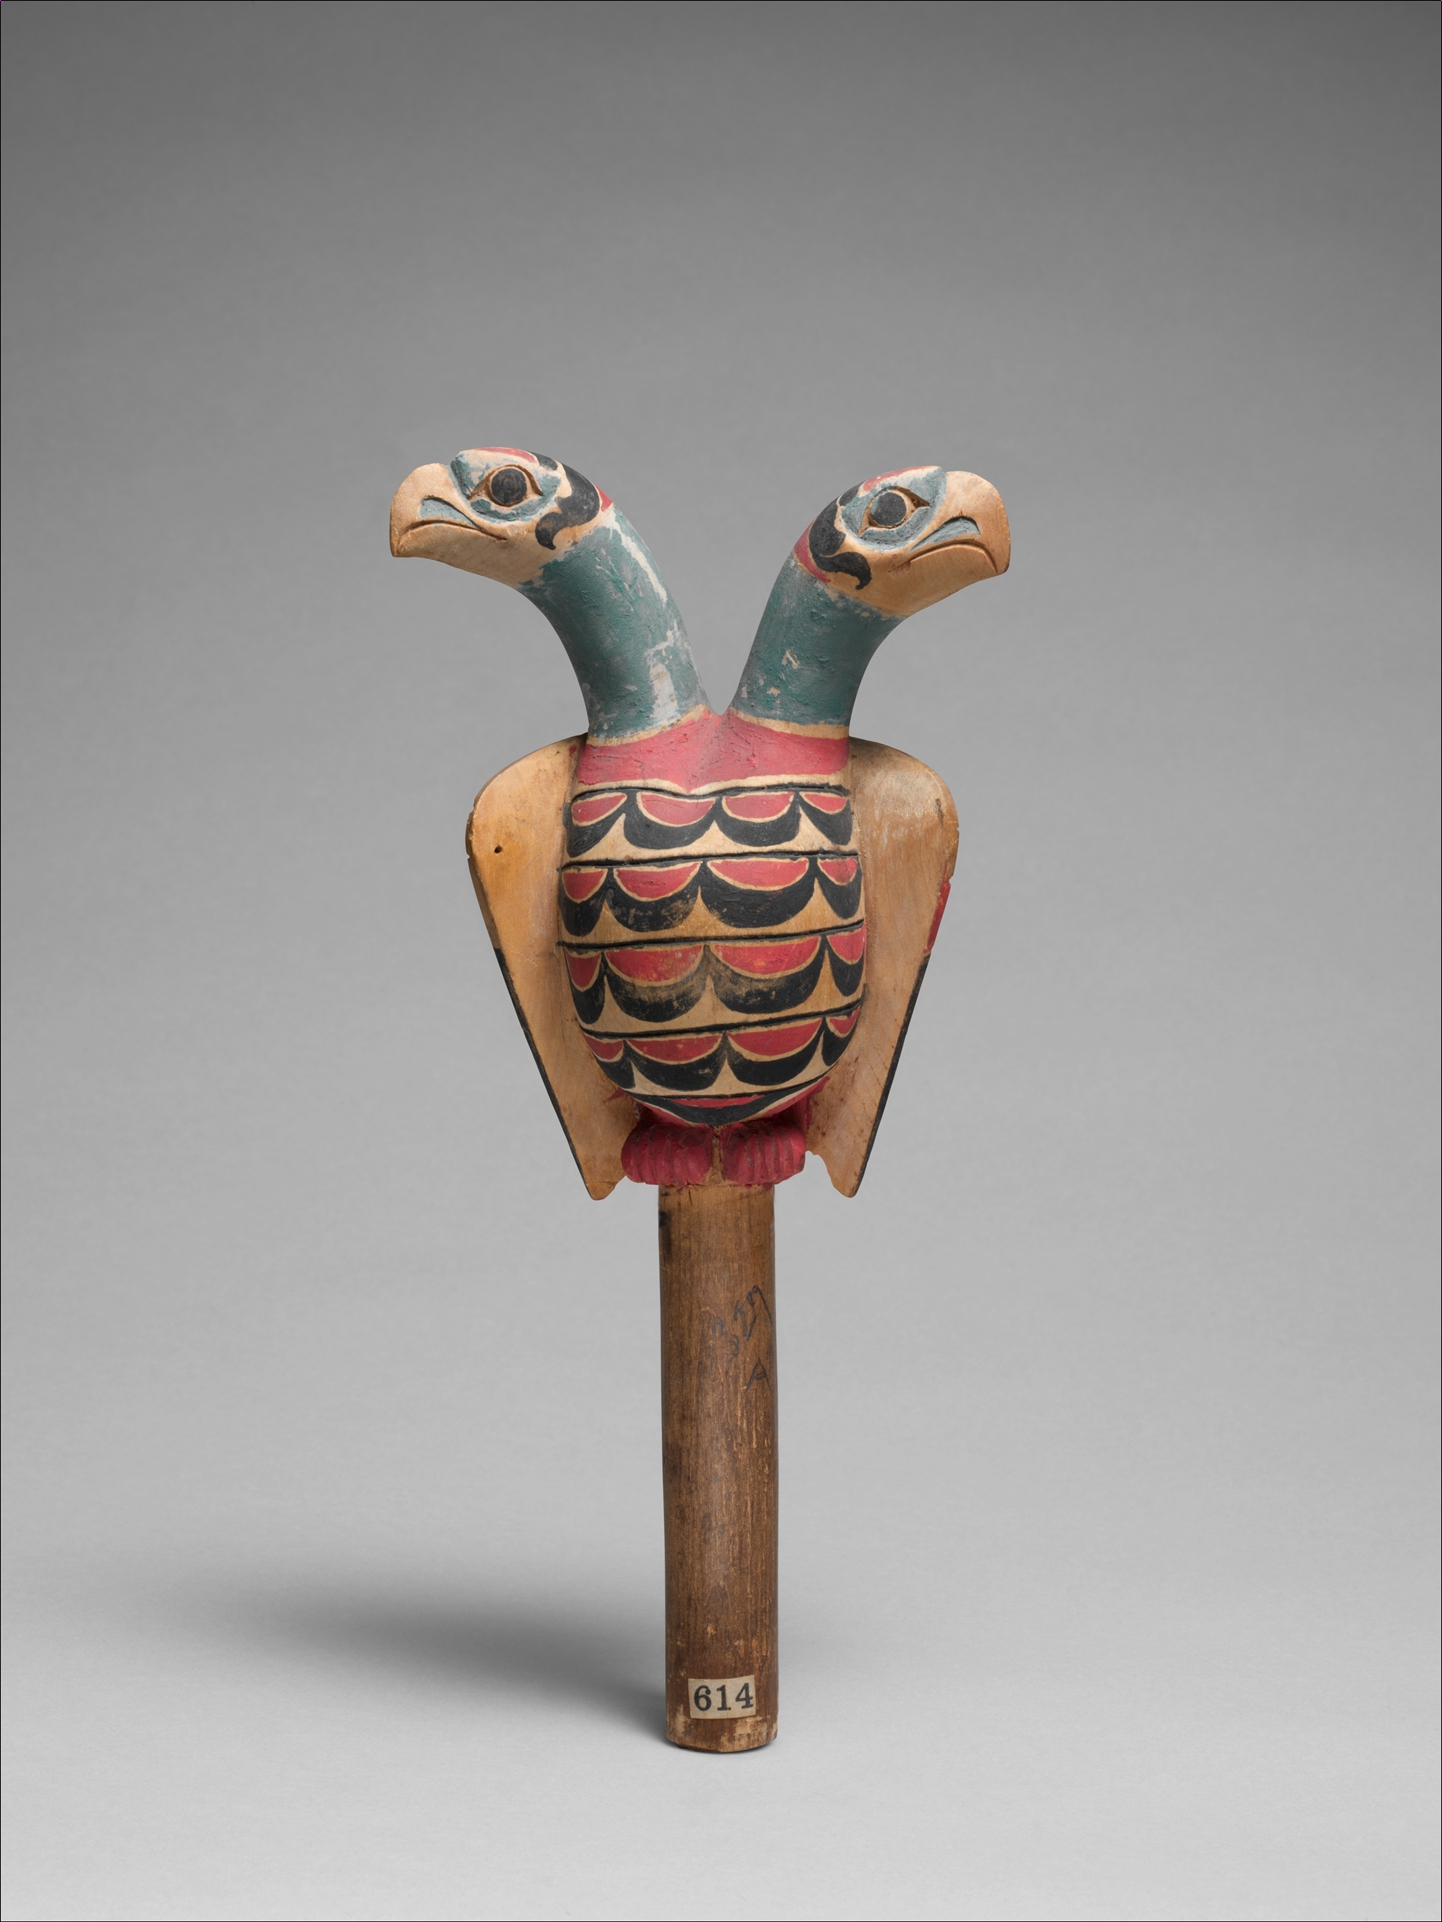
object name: rattle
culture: native american, tlingit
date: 1801-1900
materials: wood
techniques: polychrome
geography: united states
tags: birds